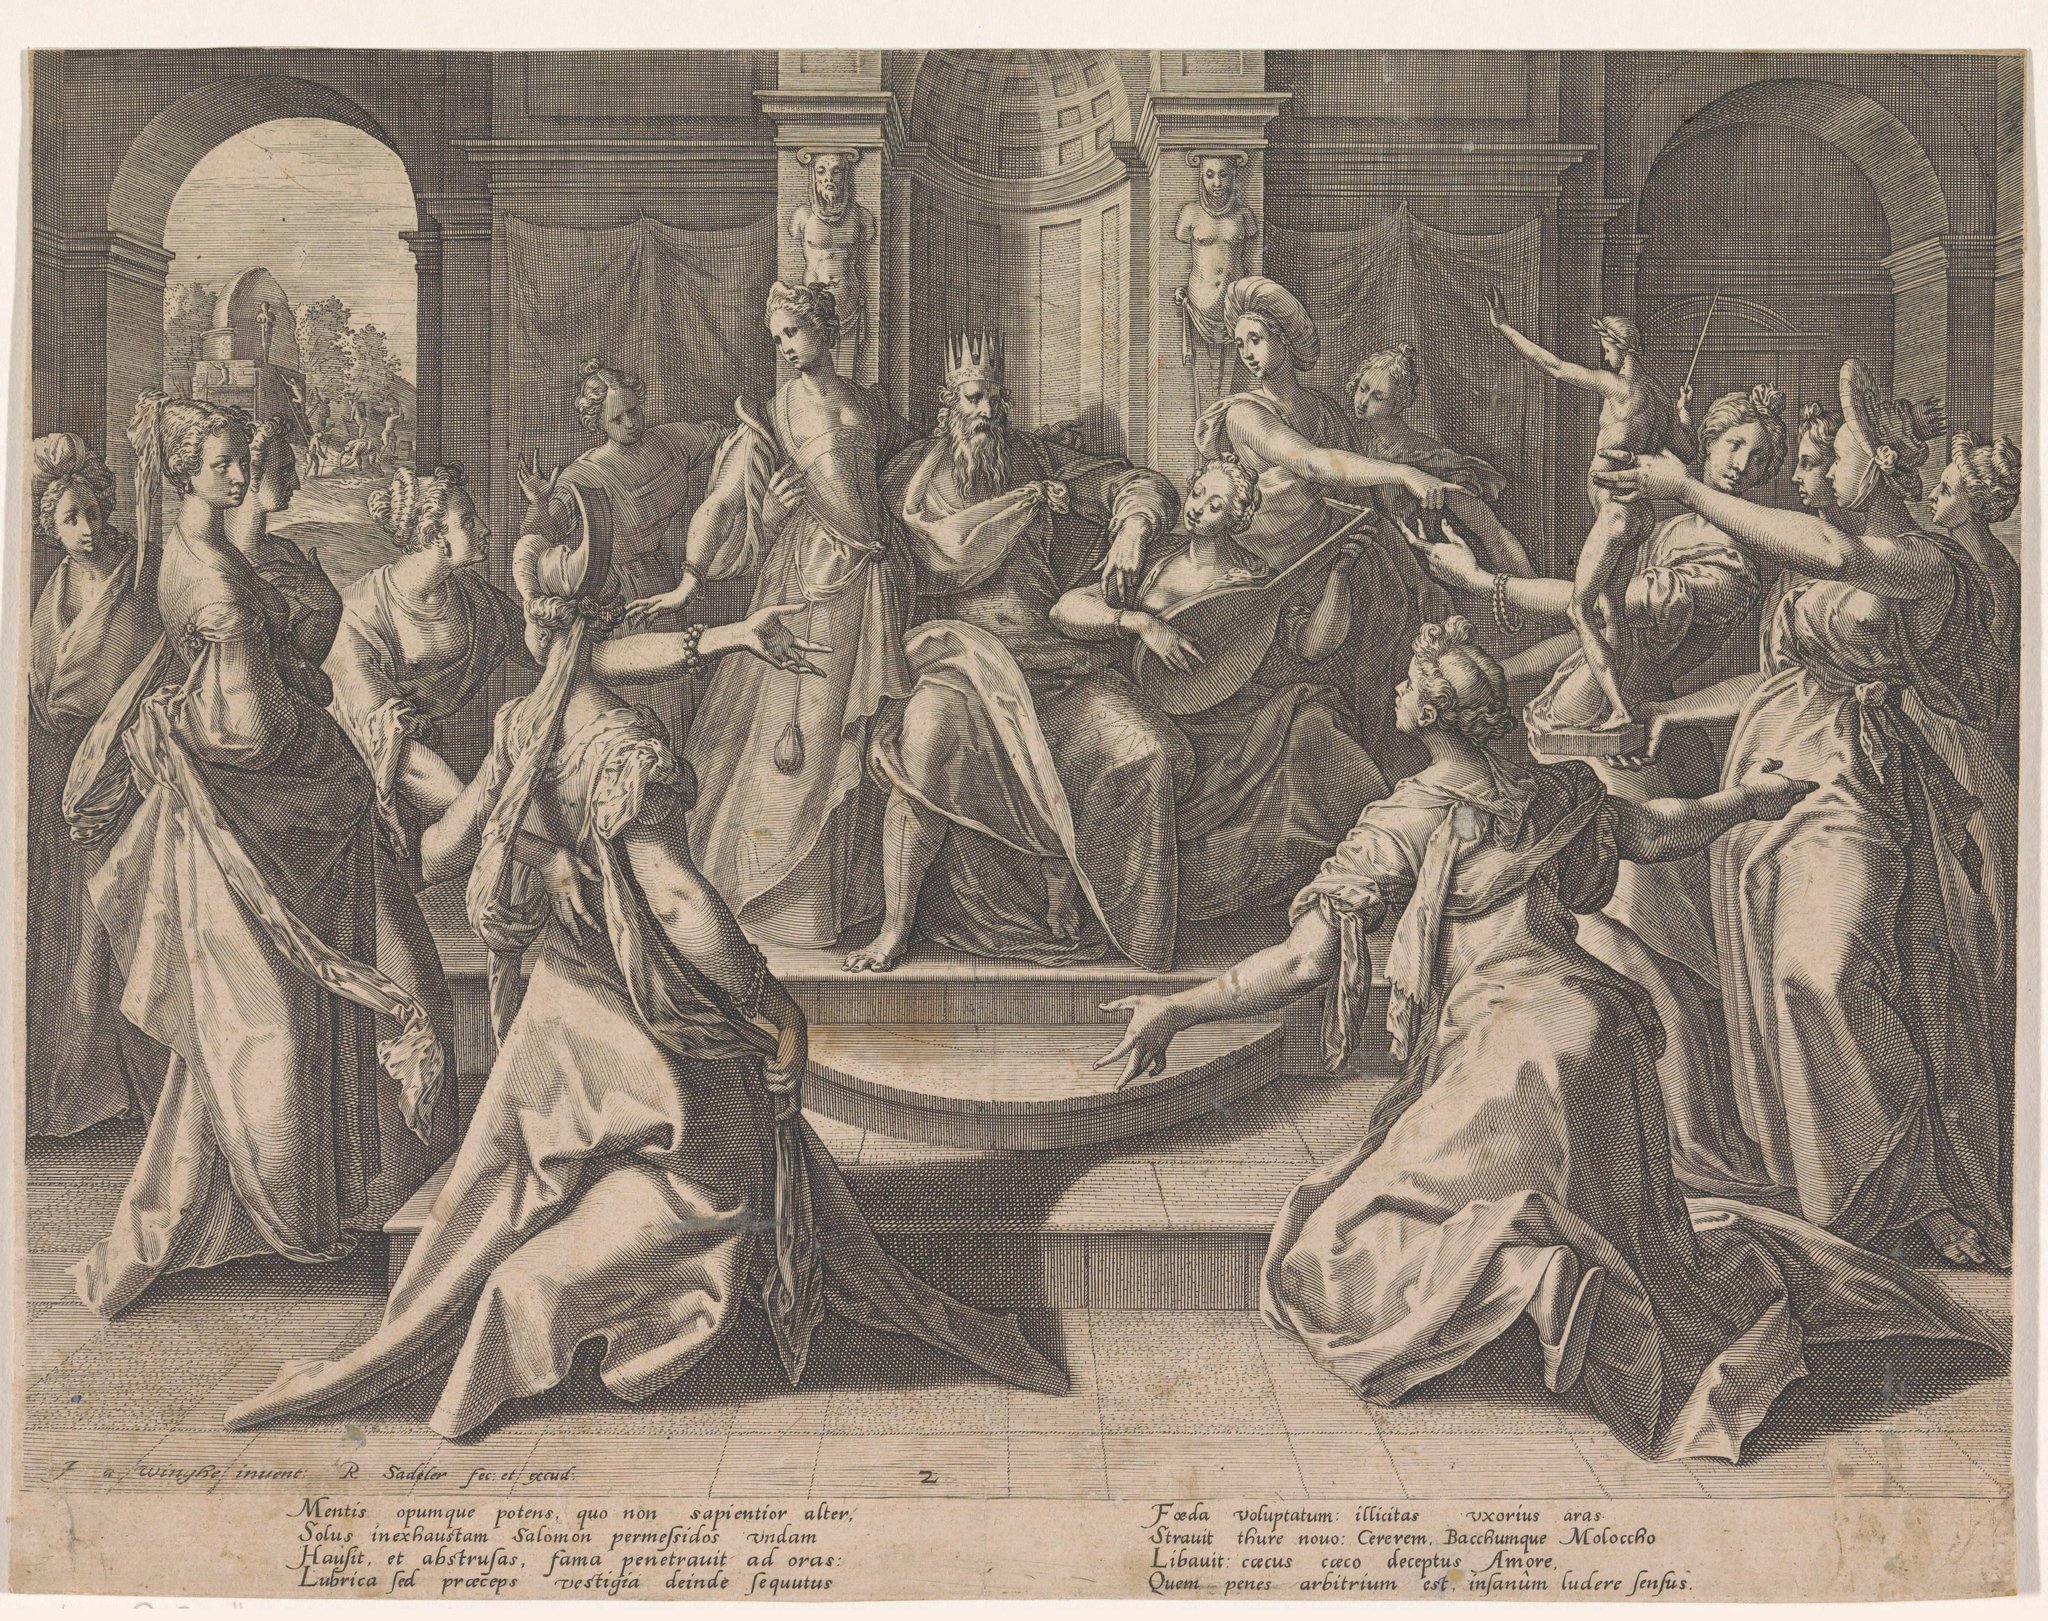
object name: print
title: Salomo's afgoderij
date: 1589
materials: paper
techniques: engraving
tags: solomon and his harem, pernicious influence of women, 'femmes fatales'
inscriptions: collector's mark: Lugt 2228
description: Koning Salomon zit op zijn troon, omringd door een gezelschap elegant geklede vrouwen. Een van hen bespeelt de luit. Een andere vrouw houdt hem een afgodsbeeld voor. Op de achtergrond links wordt een tempel voor een afgodsbeeld gebouwd